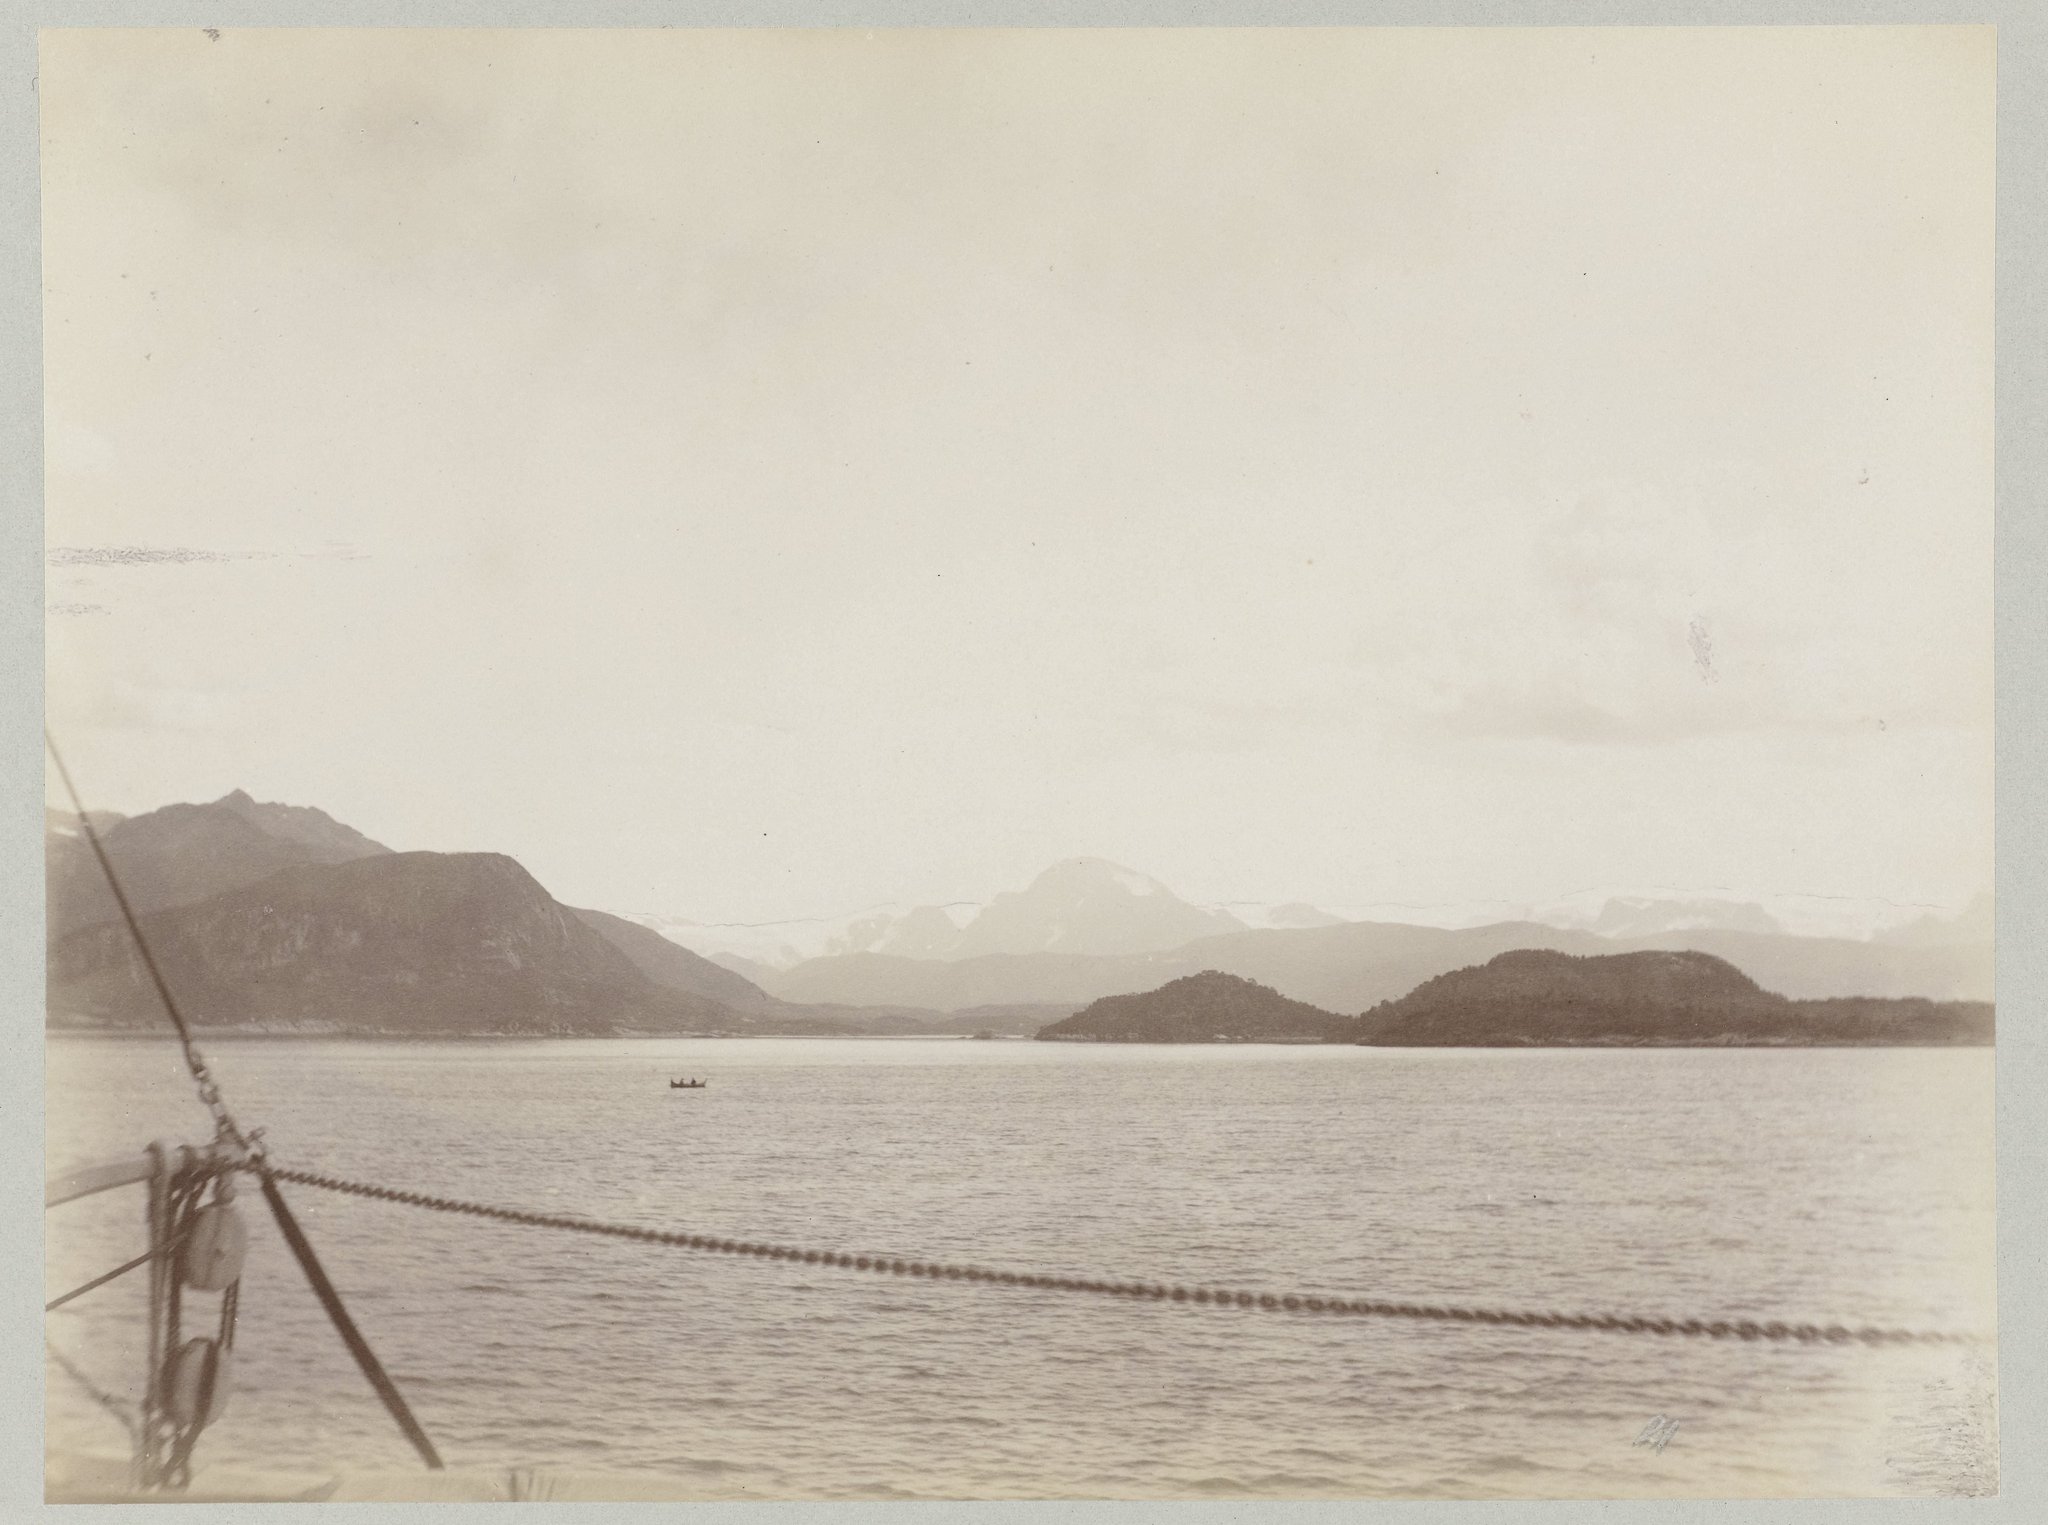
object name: photograph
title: Schneefelder und Gletscher der Folgefond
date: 1807-1889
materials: cardboard, paper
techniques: albumen print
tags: norway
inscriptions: number: ‘10’, number: ‘21’